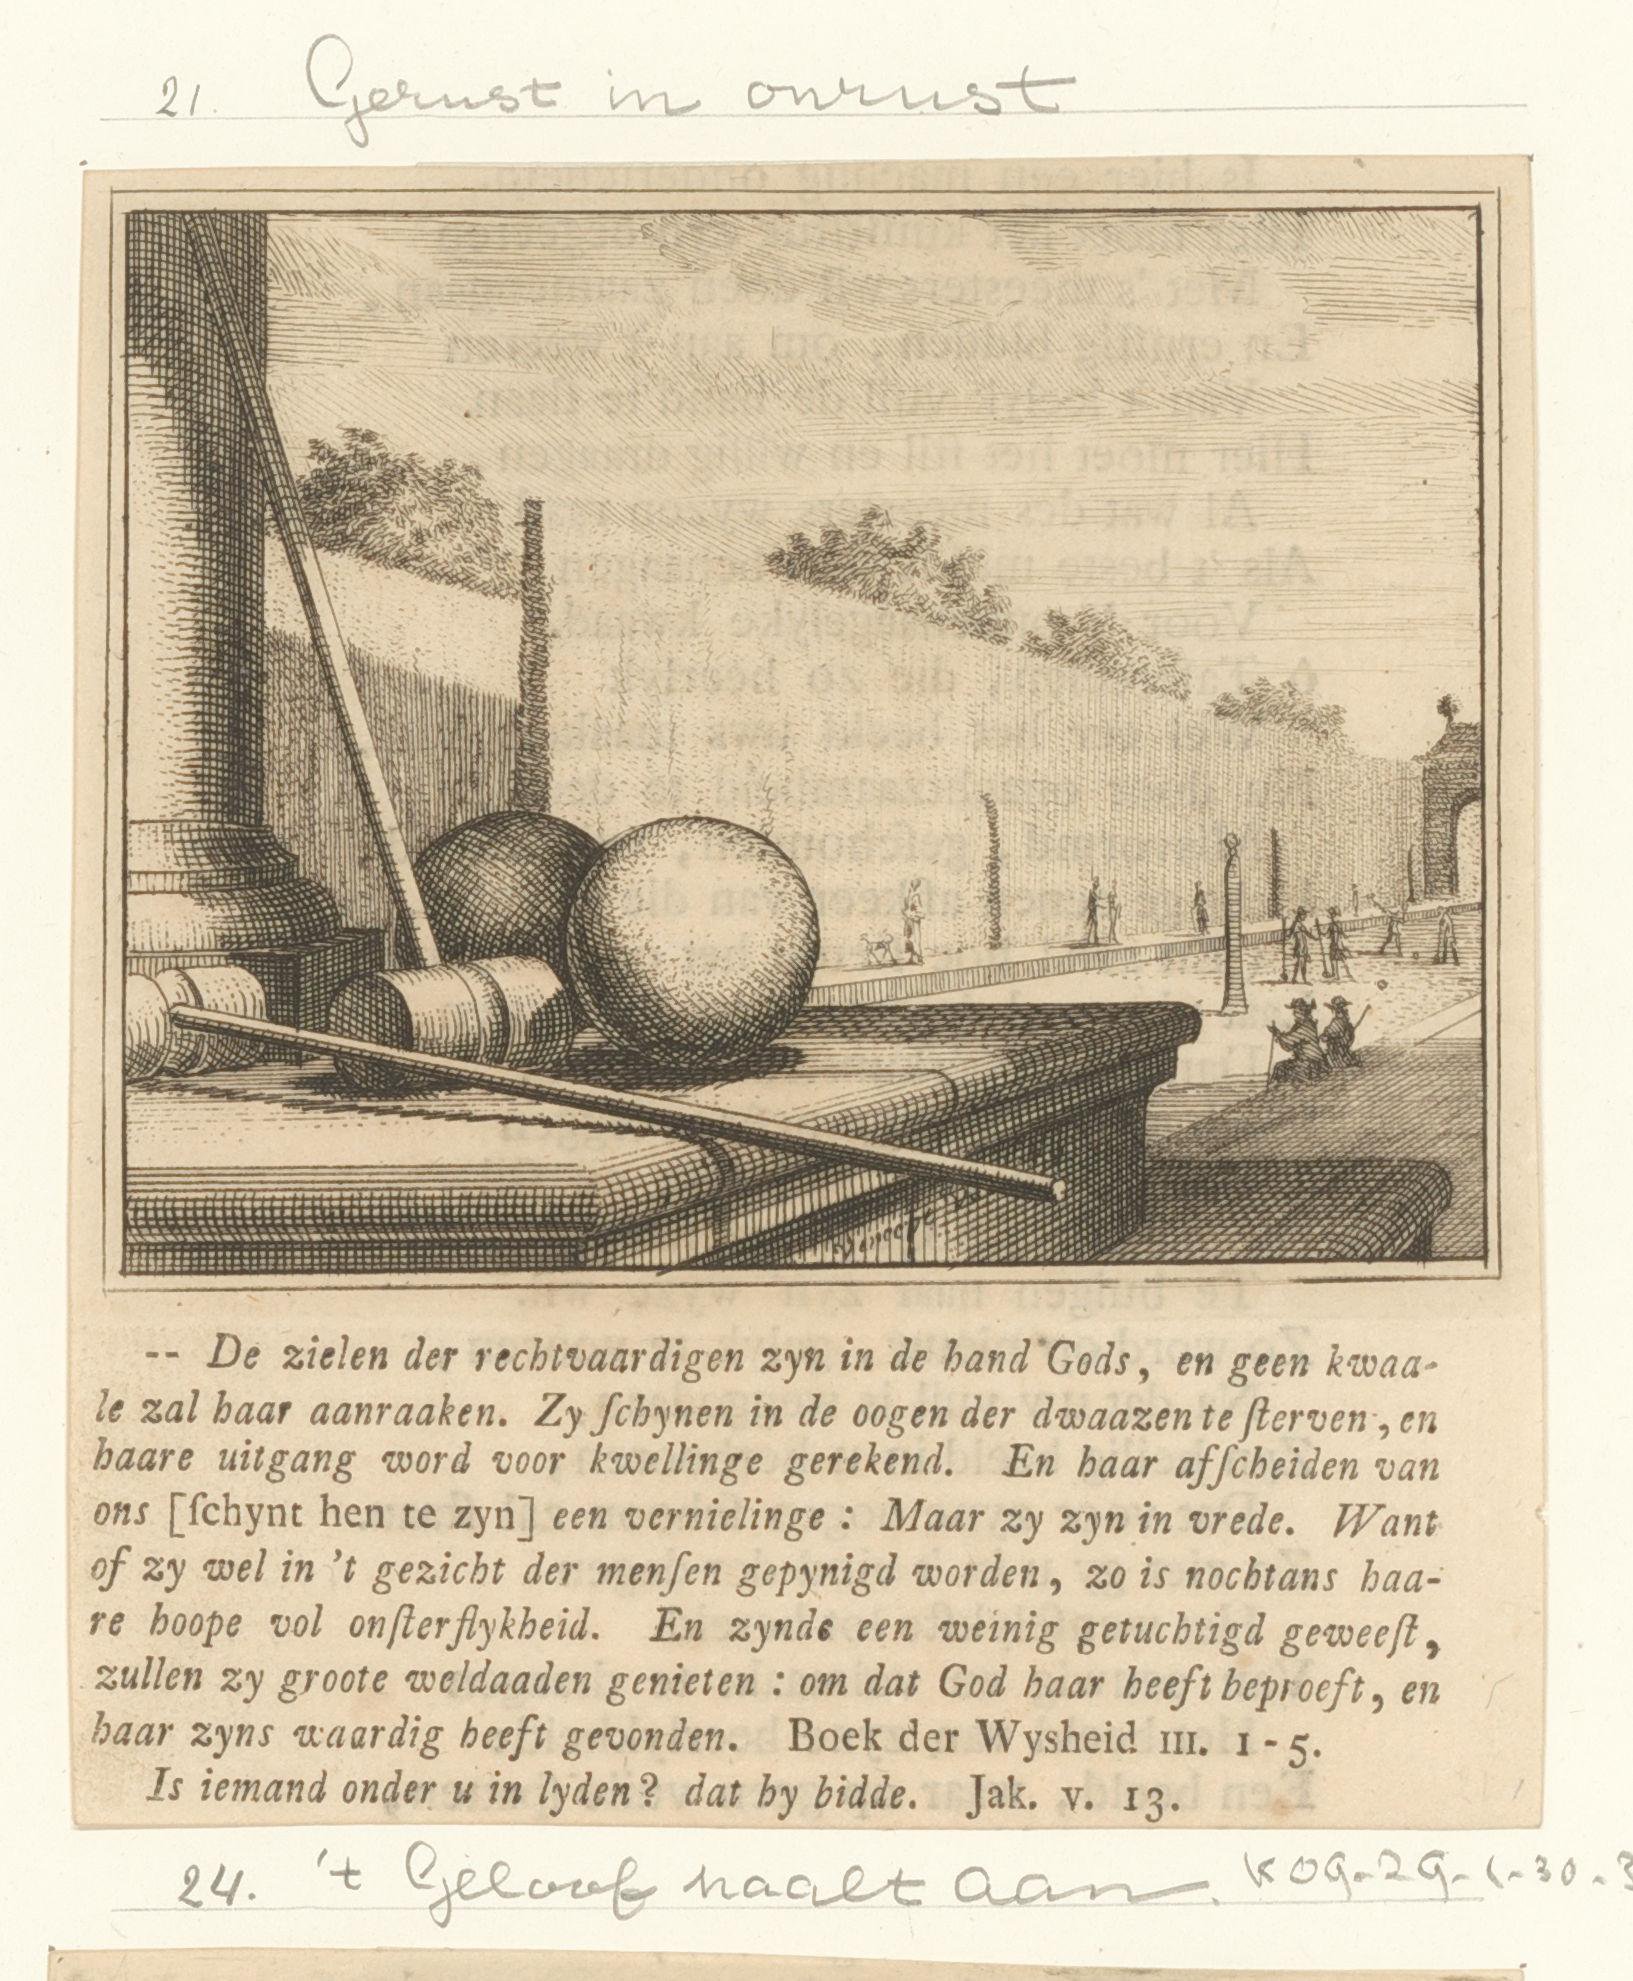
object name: print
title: Speelballen en hamers in een Franse tuin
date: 1758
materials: paper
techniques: etching, letterpress printing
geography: haarlem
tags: proverbs, sayings, etc., garden pond, games using special objects (marbles, top, hoop, etc.)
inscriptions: collector's mark: Lugt 1641, stamp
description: Embleem bij het motto: Gerust in onrust. Onderaan een negenregelige tekst in het Nederlands. Onderwerpsrubrieken binnen de Atlas Zeden en Gewoonten: Zeden en Gewoonten in engeren zin. Volksleven. Zinnebeeldige voorstellingen uit het volkleven op serieprenten. Maanden en diversen (allegorieën).